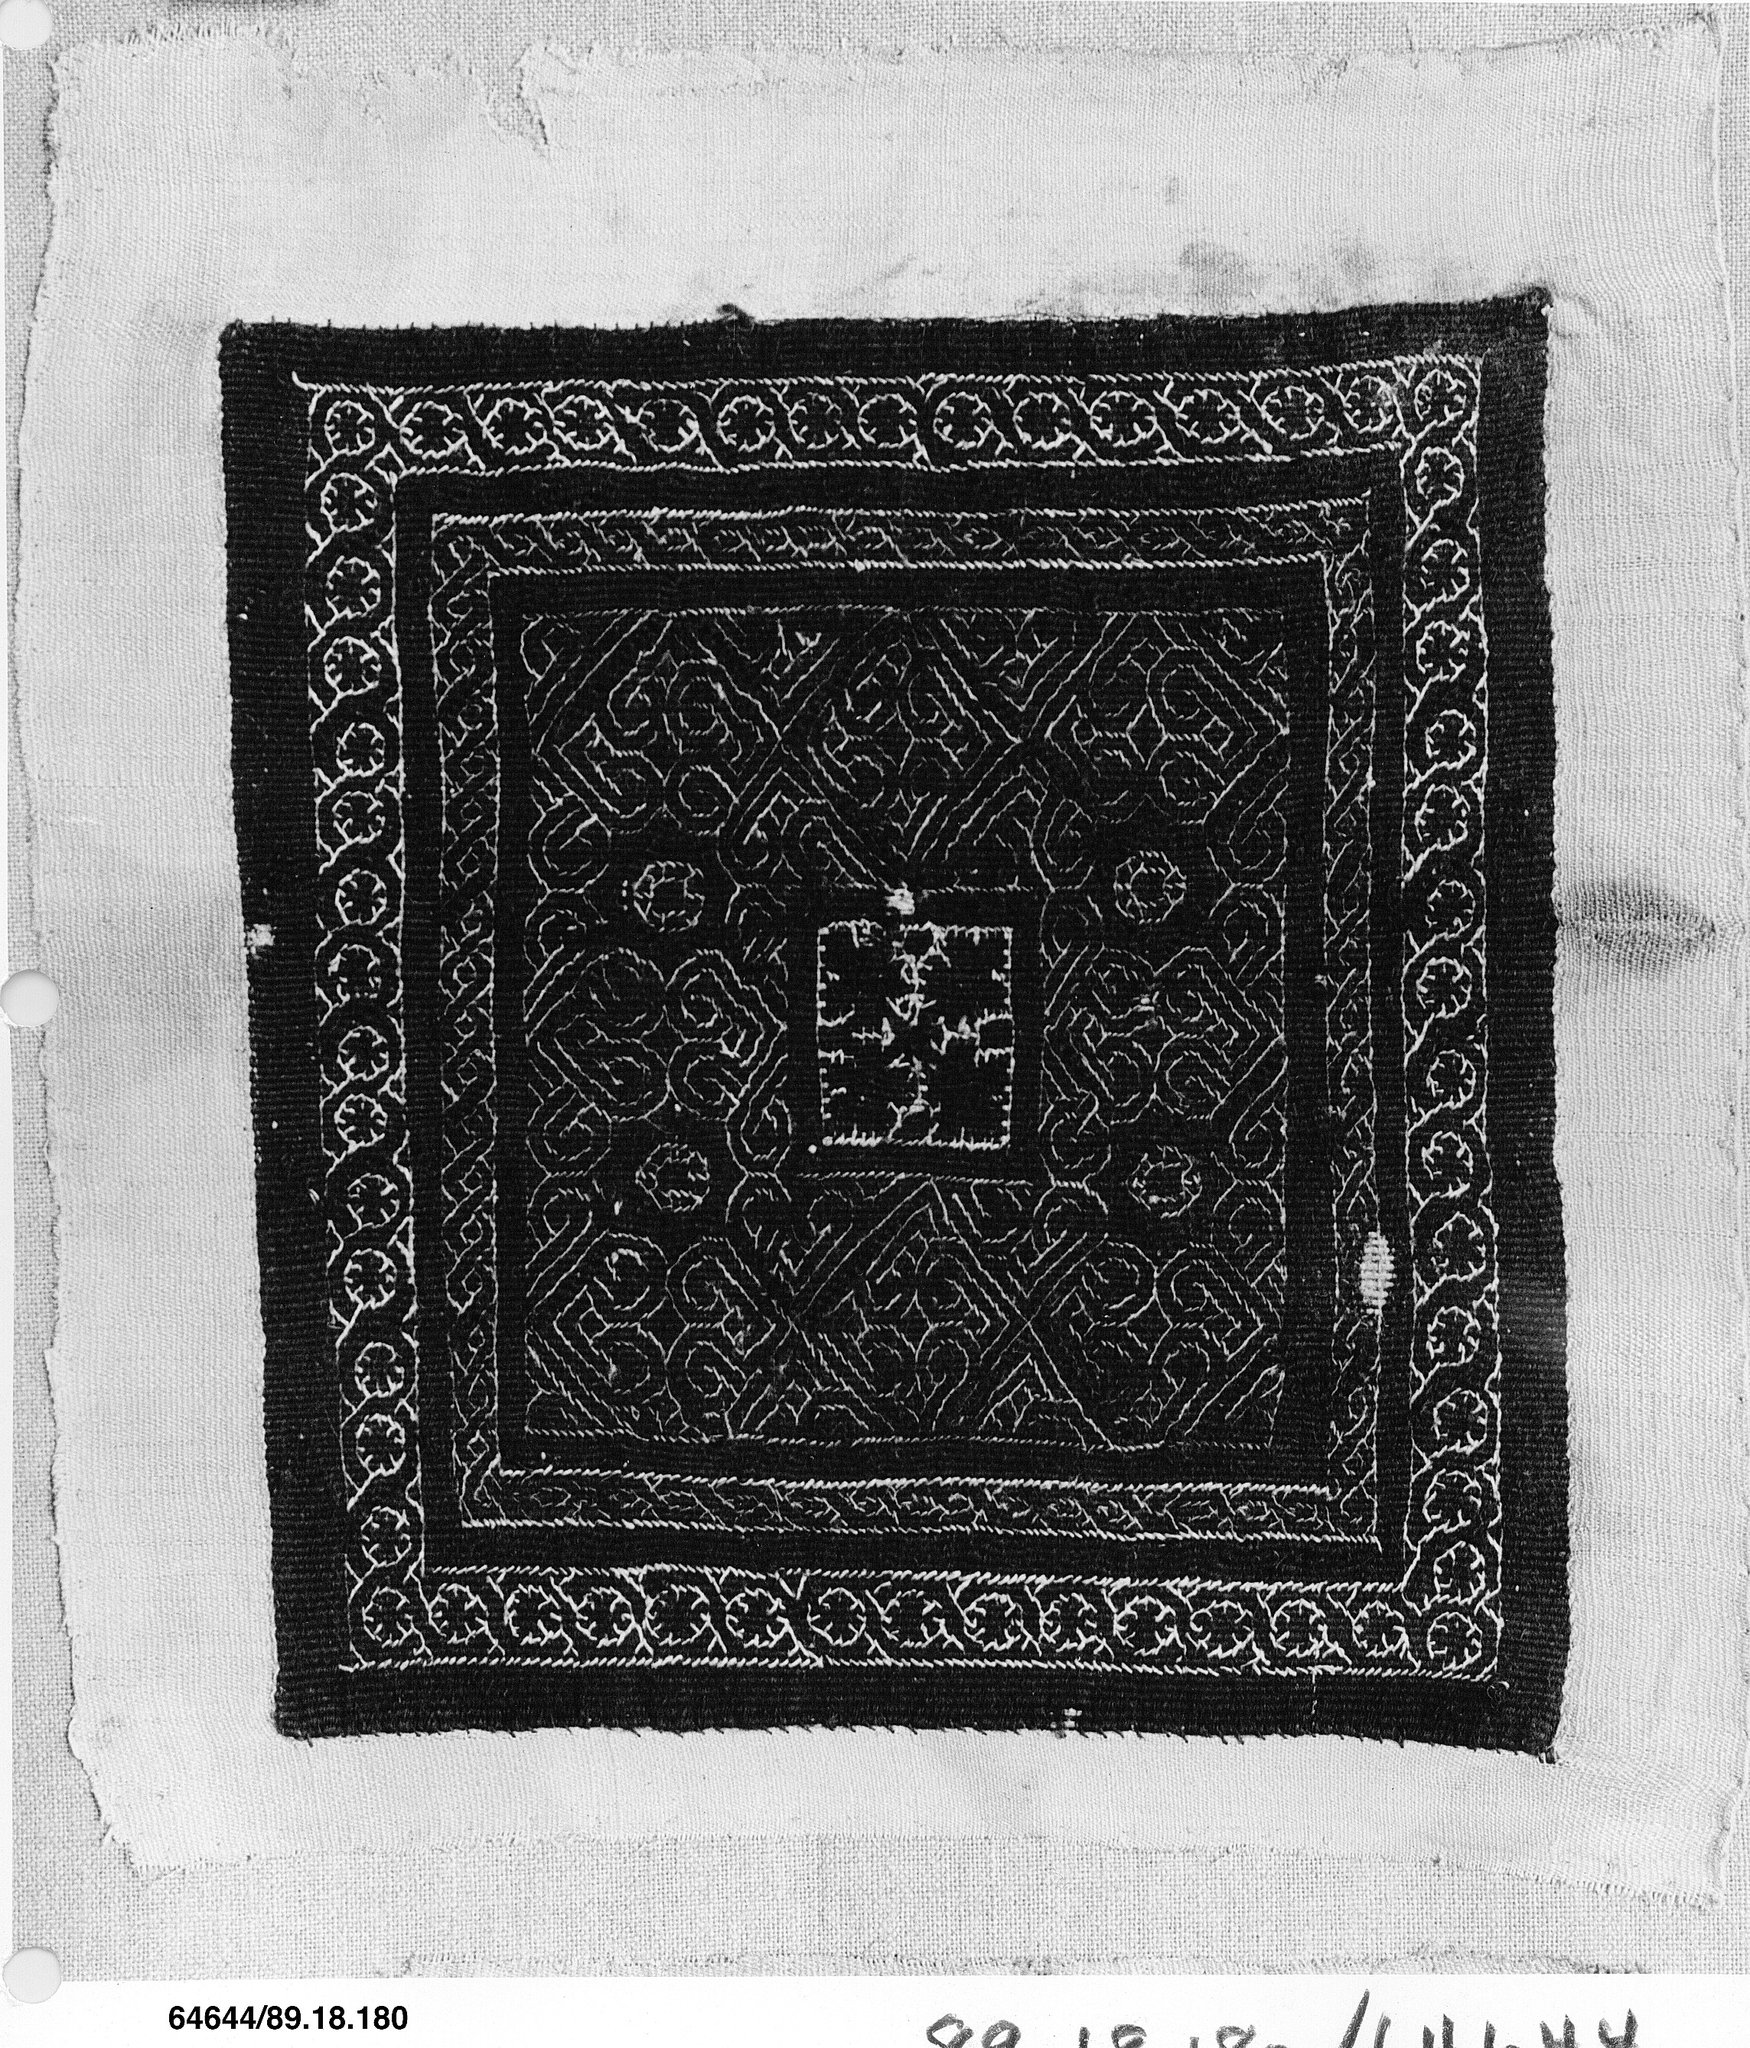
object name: textile fragment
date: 201-400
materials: linen, wool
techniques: weave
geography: egypt